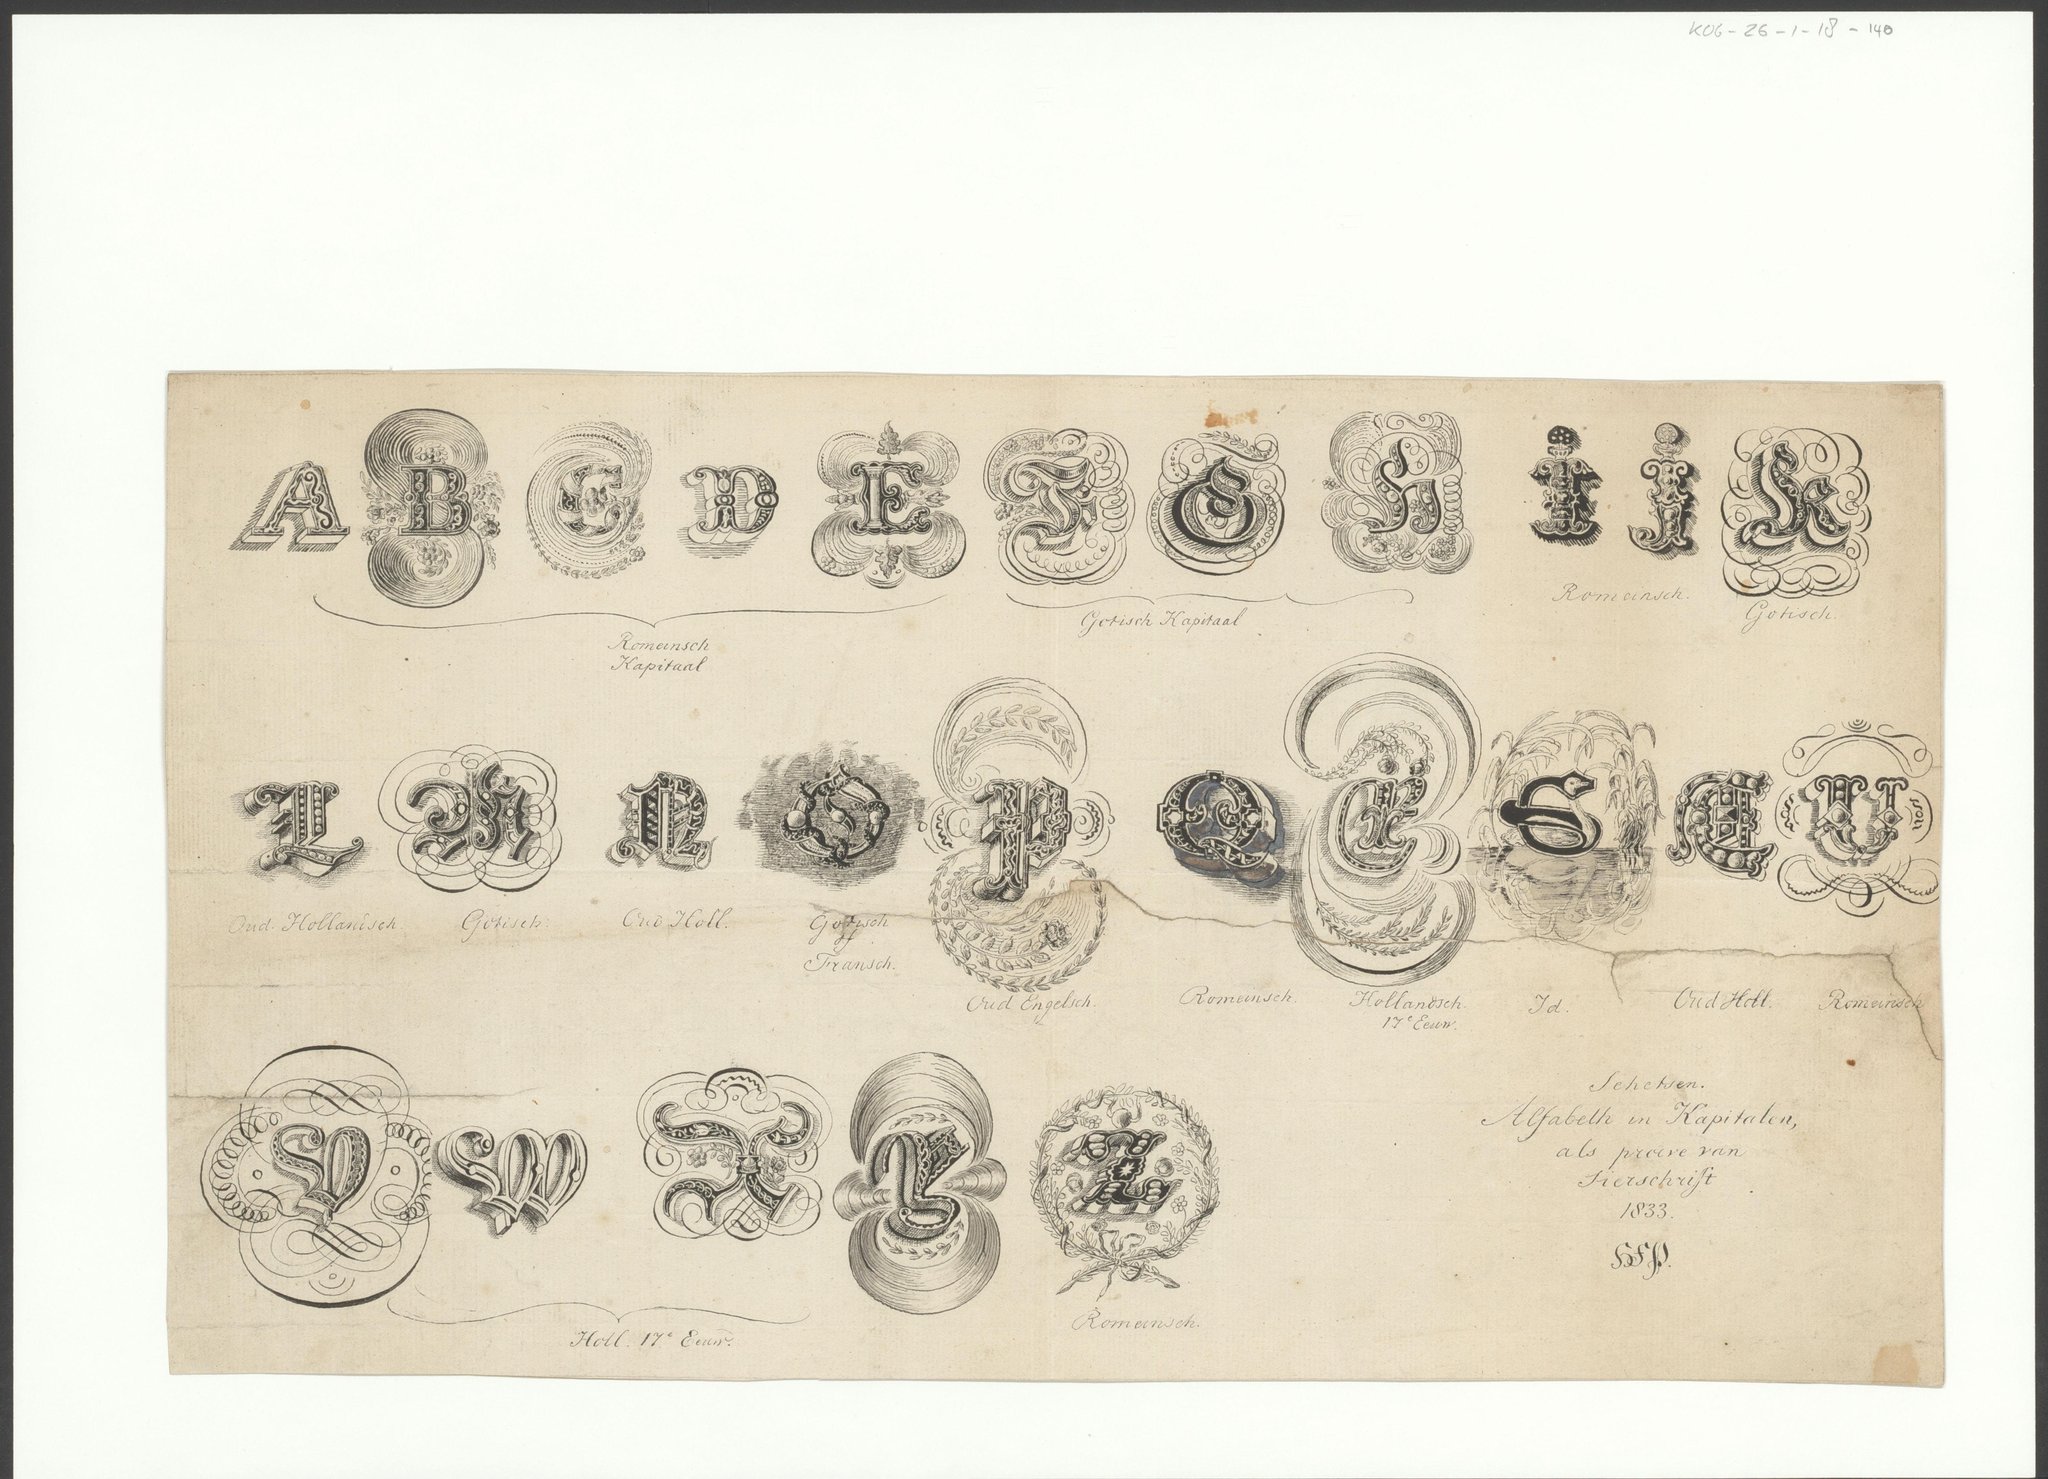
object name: calligraphy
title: Ontwerp voor sierletters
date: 1833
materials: ink, paper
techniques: pen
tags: fancy letters, calligraphy, roman script; scripts based on the roman alphabet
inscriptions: signature: ‘HFP’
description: Ontwerp van sierletters van het hele alfabet. De letters zijn een mix van Romeins, Gotisch en Oud-Hollands schrift. Onderaan de tekst: Schetsen Alfabeth in Kapitalen, als proeve van sierschrift 1833. Onderwerpsrubrieken binnen de Atlas Zeden en Gewoonten: Schoone kunsten, Pennekunst.